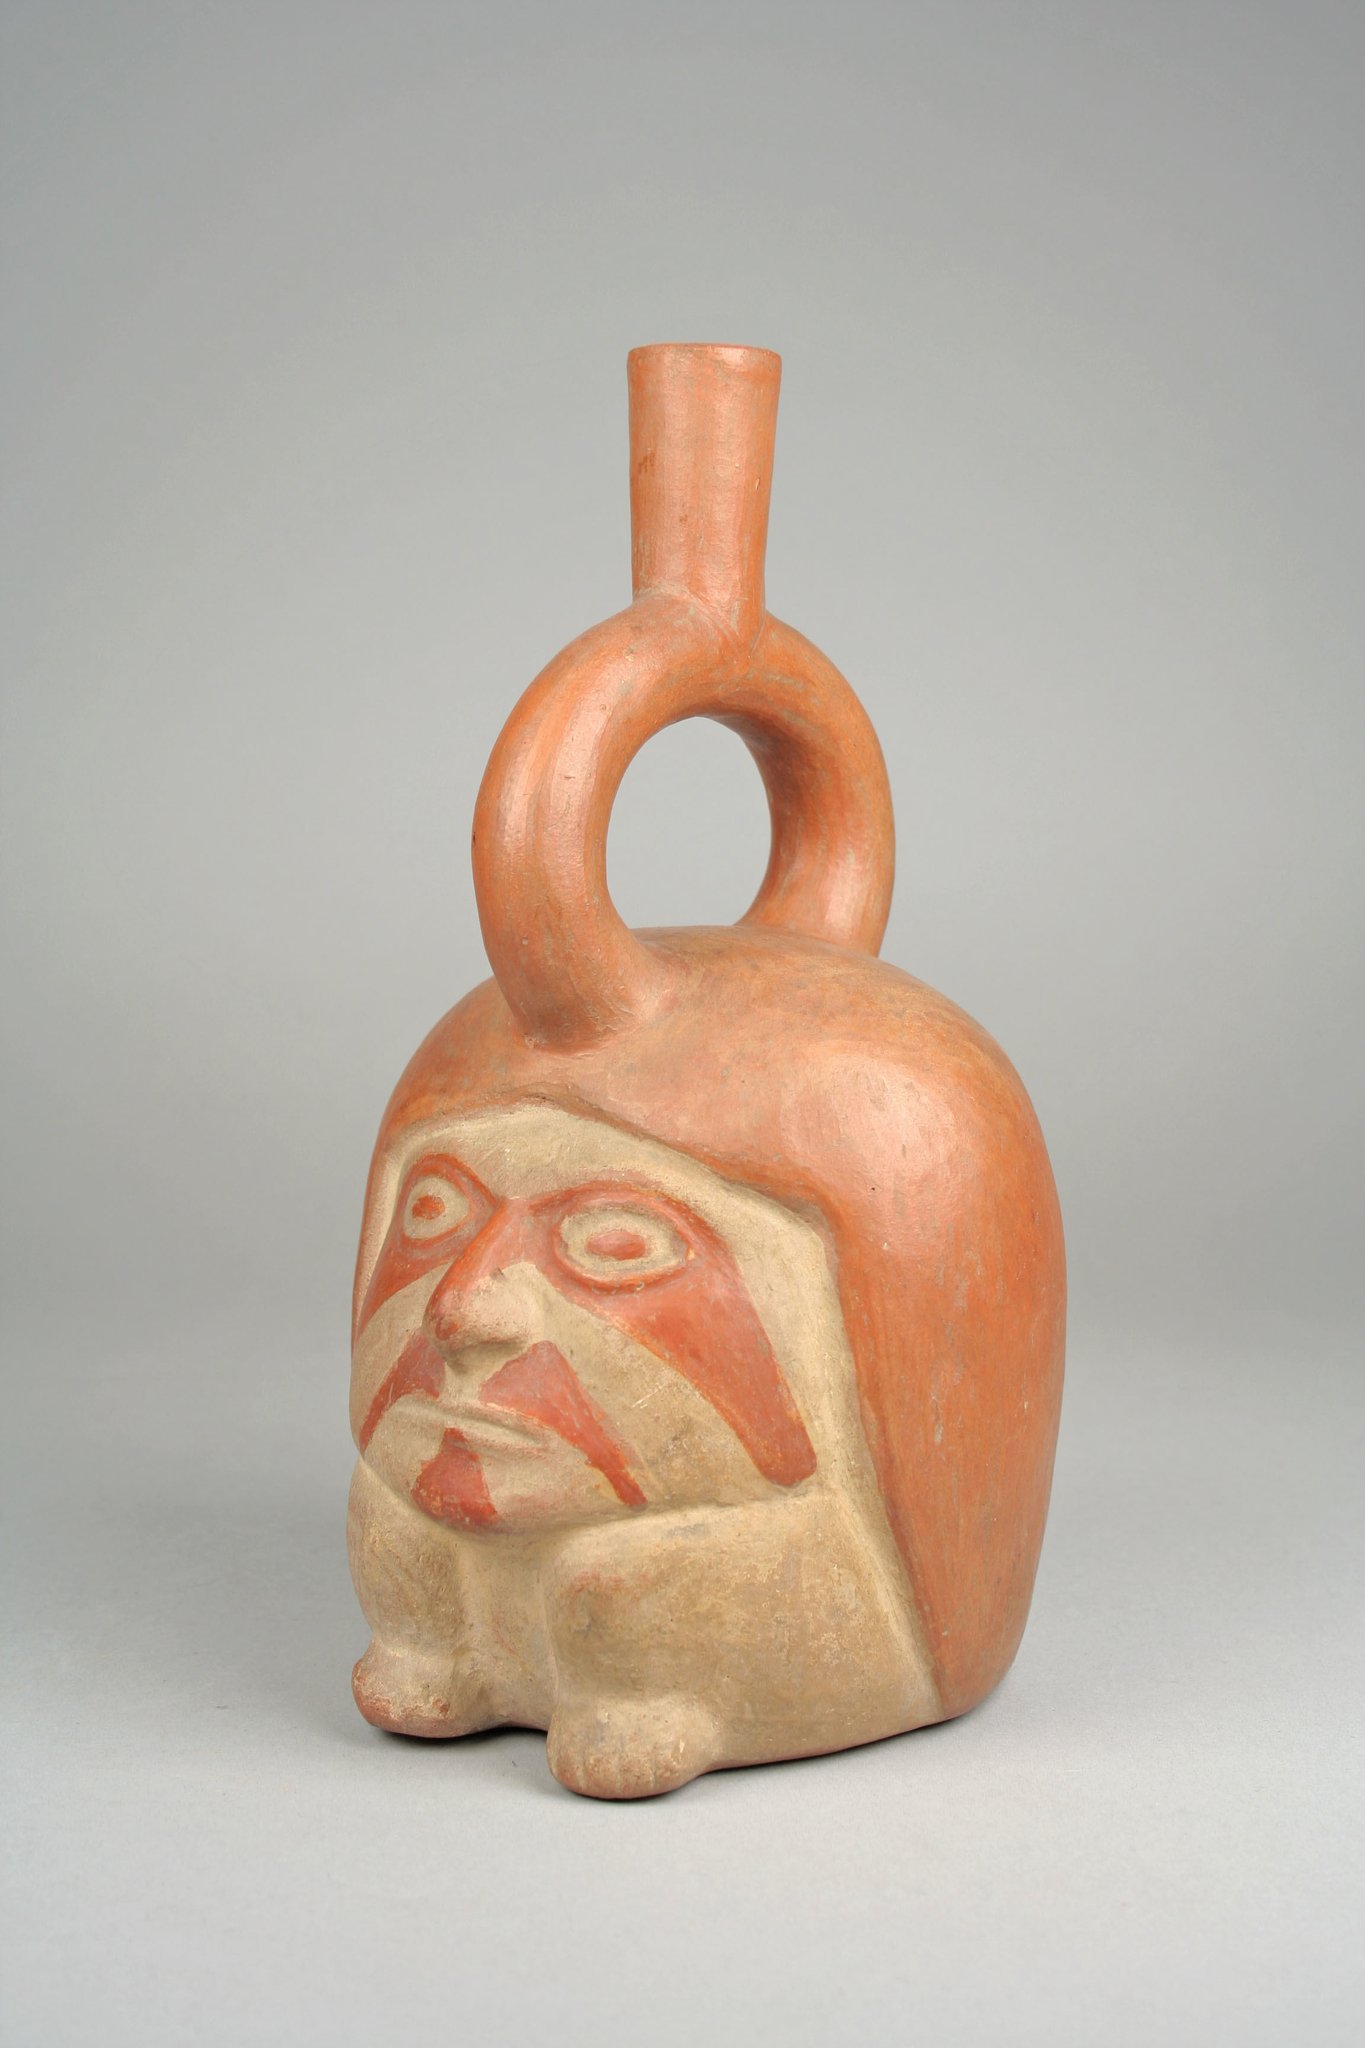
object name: bottle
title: Stirrup Spout Bottle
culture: moche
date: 100 BCE-700 CE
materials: ceramic, pigment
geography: peru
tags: faces